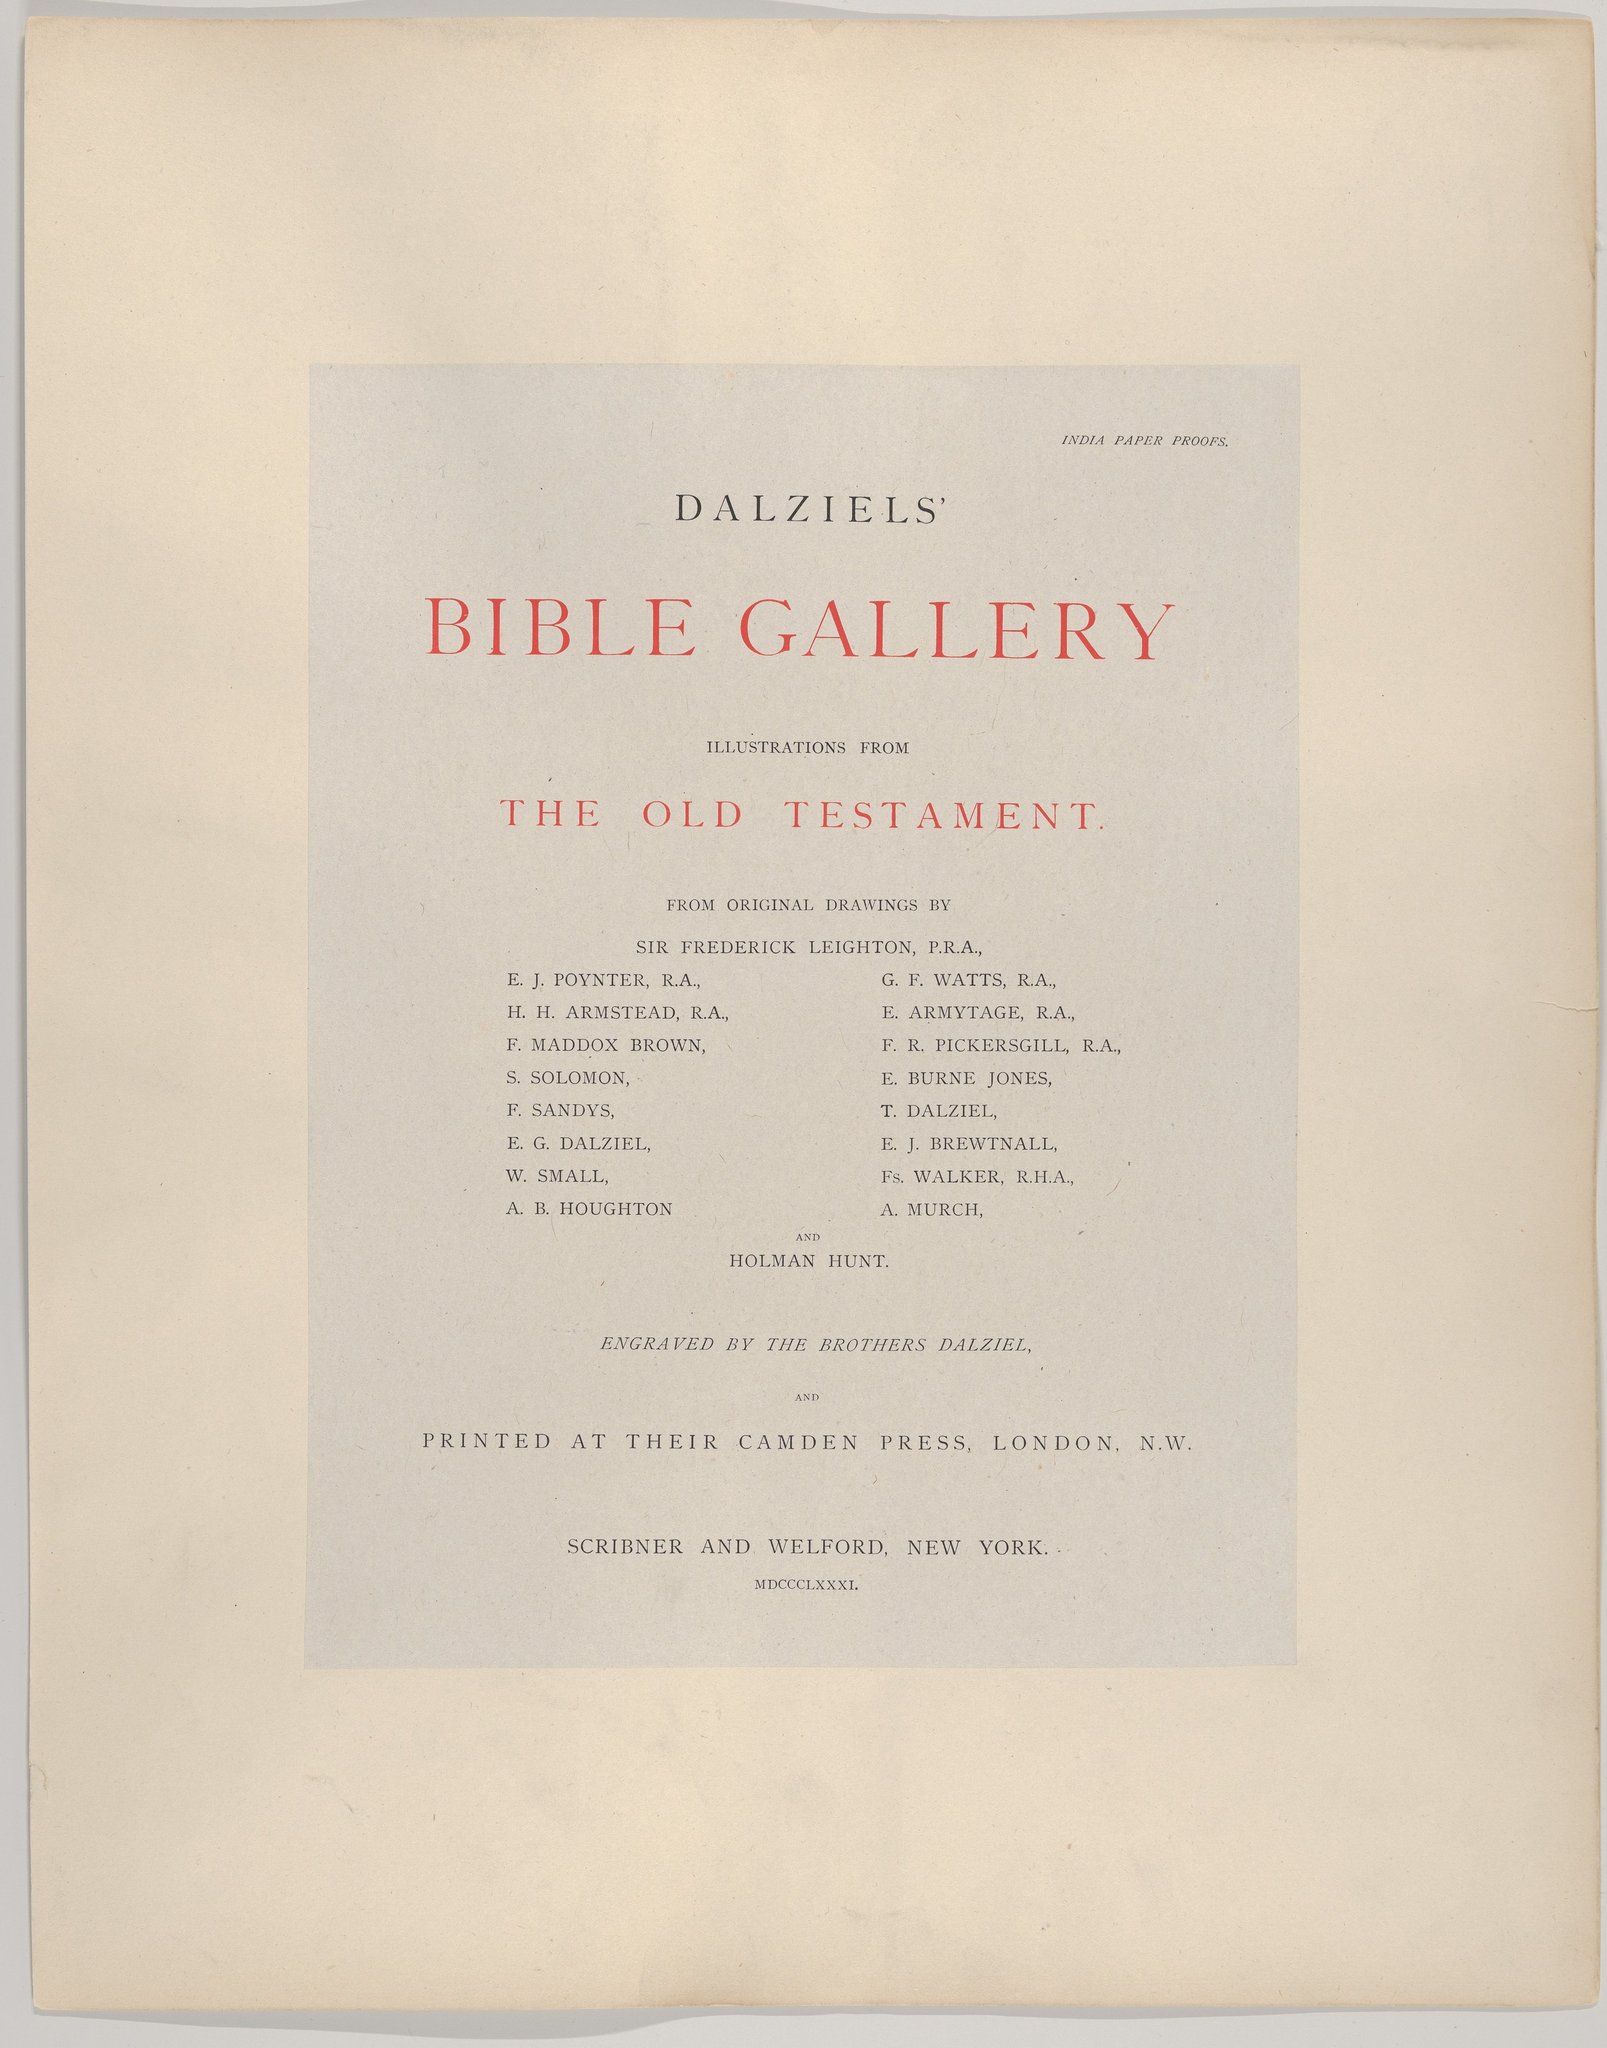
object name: portfolio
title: Dalziels' Bible Gallery: Illustrations from the Old Testament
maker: dalziel brothers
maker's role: engraver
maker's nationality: british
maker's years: 1839-1893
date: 1881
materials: paper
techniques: engraving